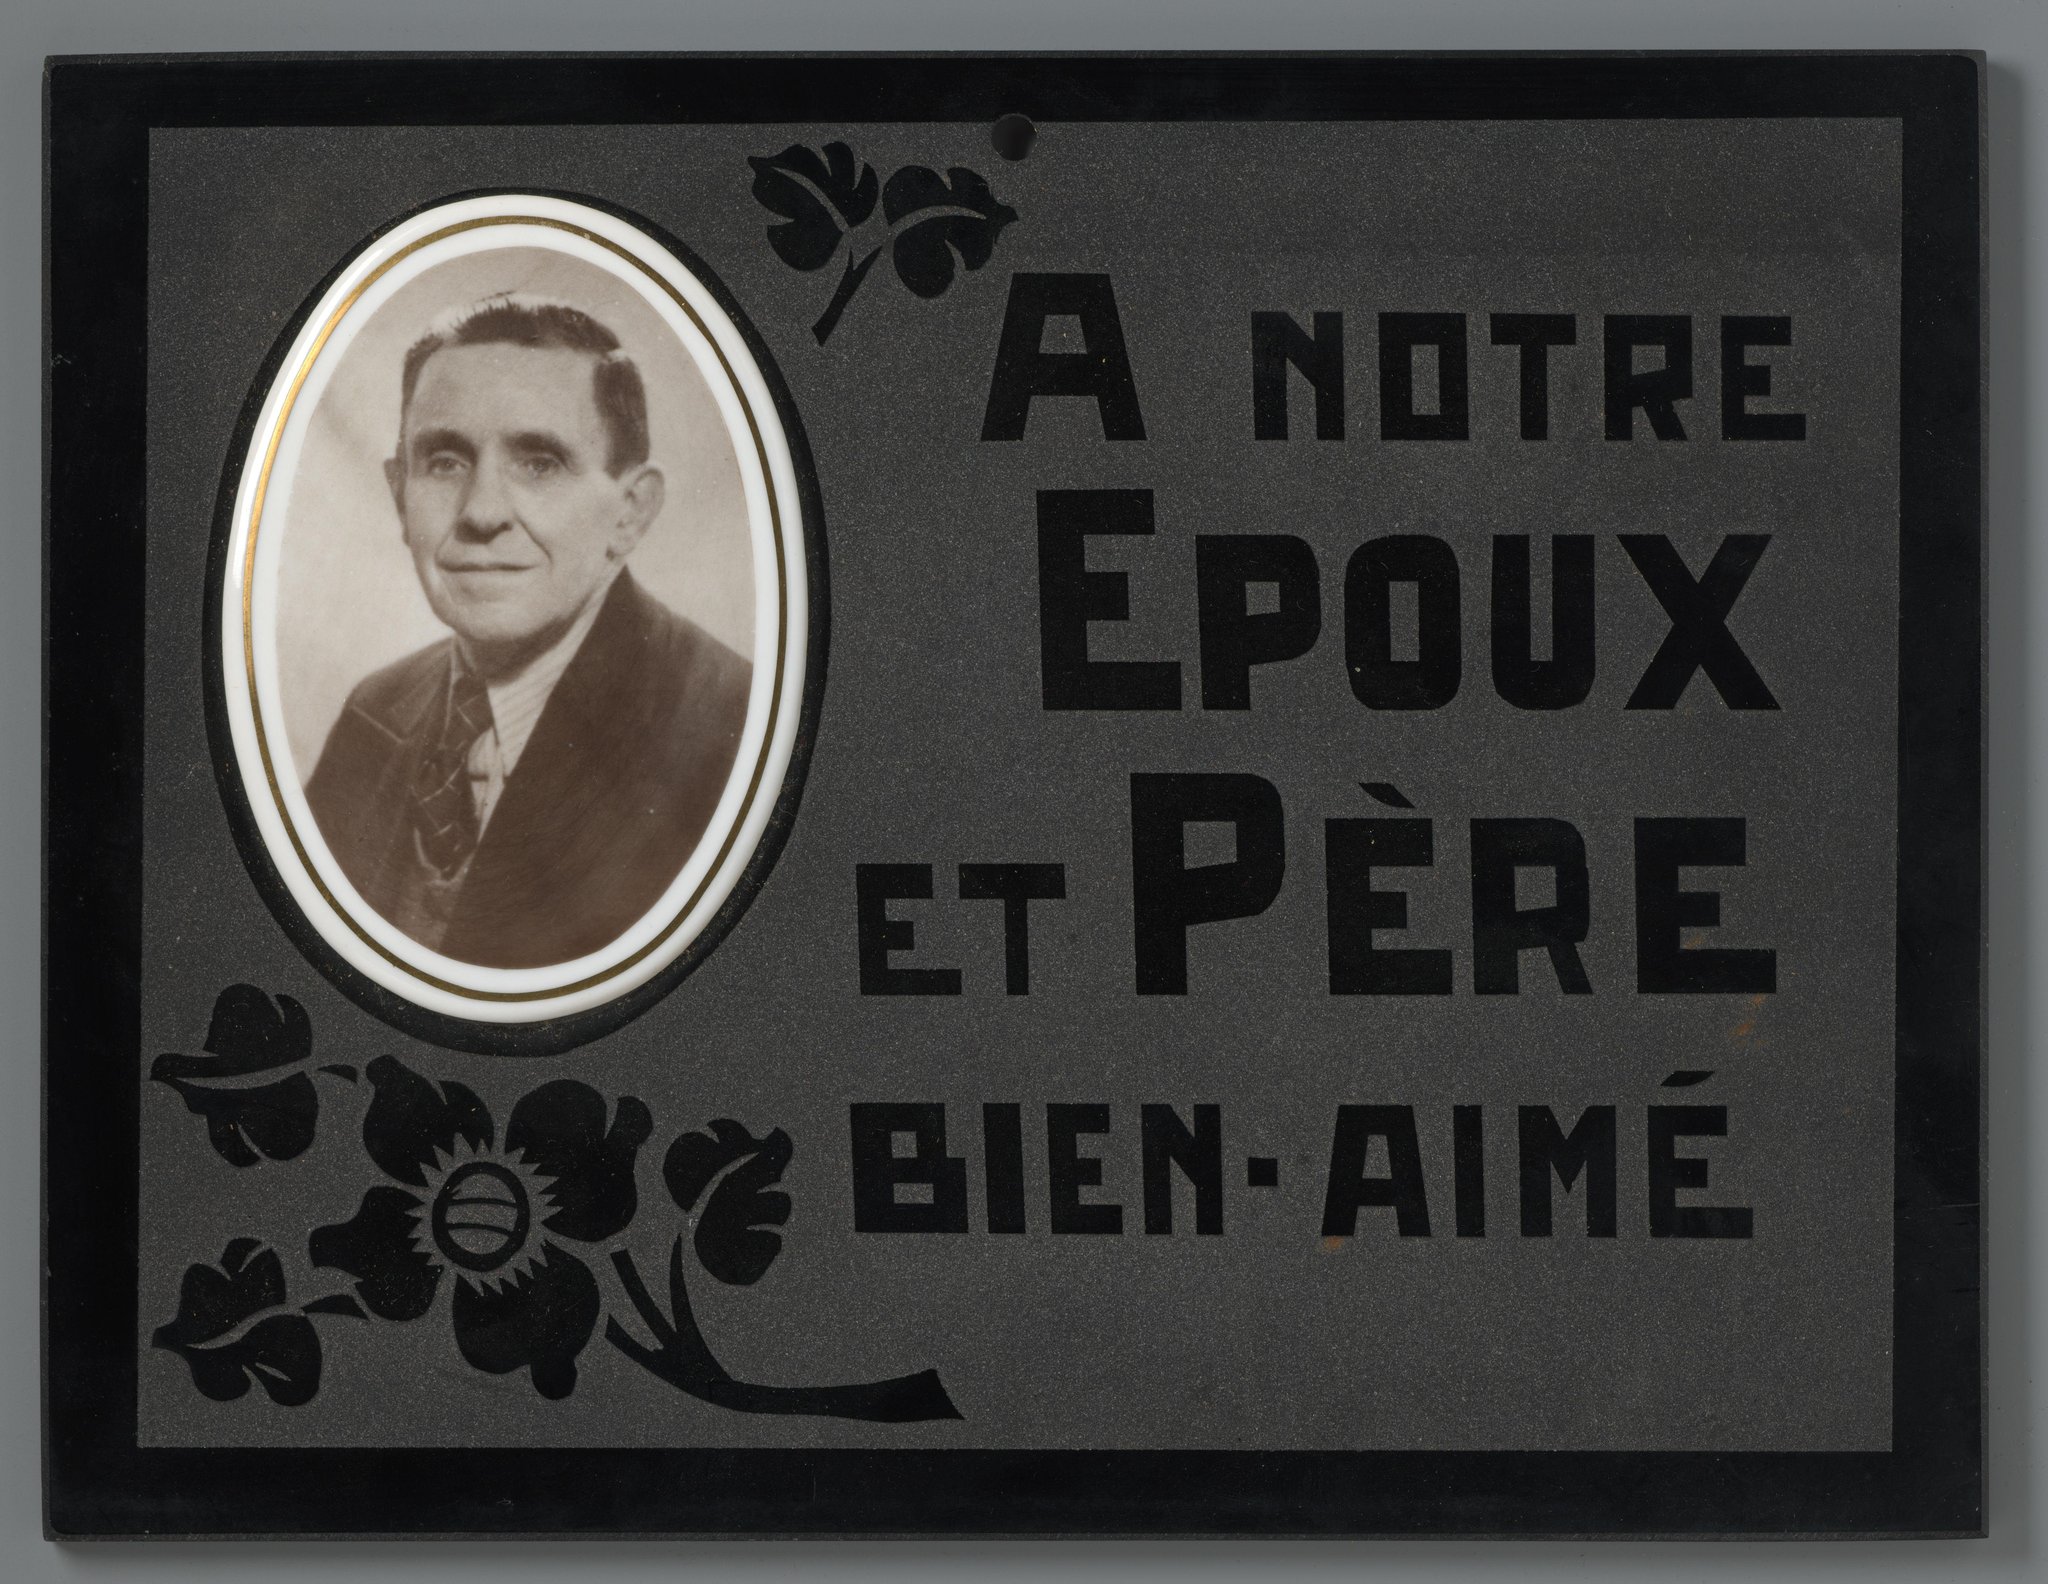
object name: sepulchral monument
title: A notre epoux et père bien-aimé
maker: Anonymous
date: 1900-1960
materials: porcelain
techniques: porcelain photography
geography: france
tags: gravestone, tombstone, historical persons not known by name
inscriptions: inscription: ‘A notre/ Epoux/ et Père/ bien-aimé’